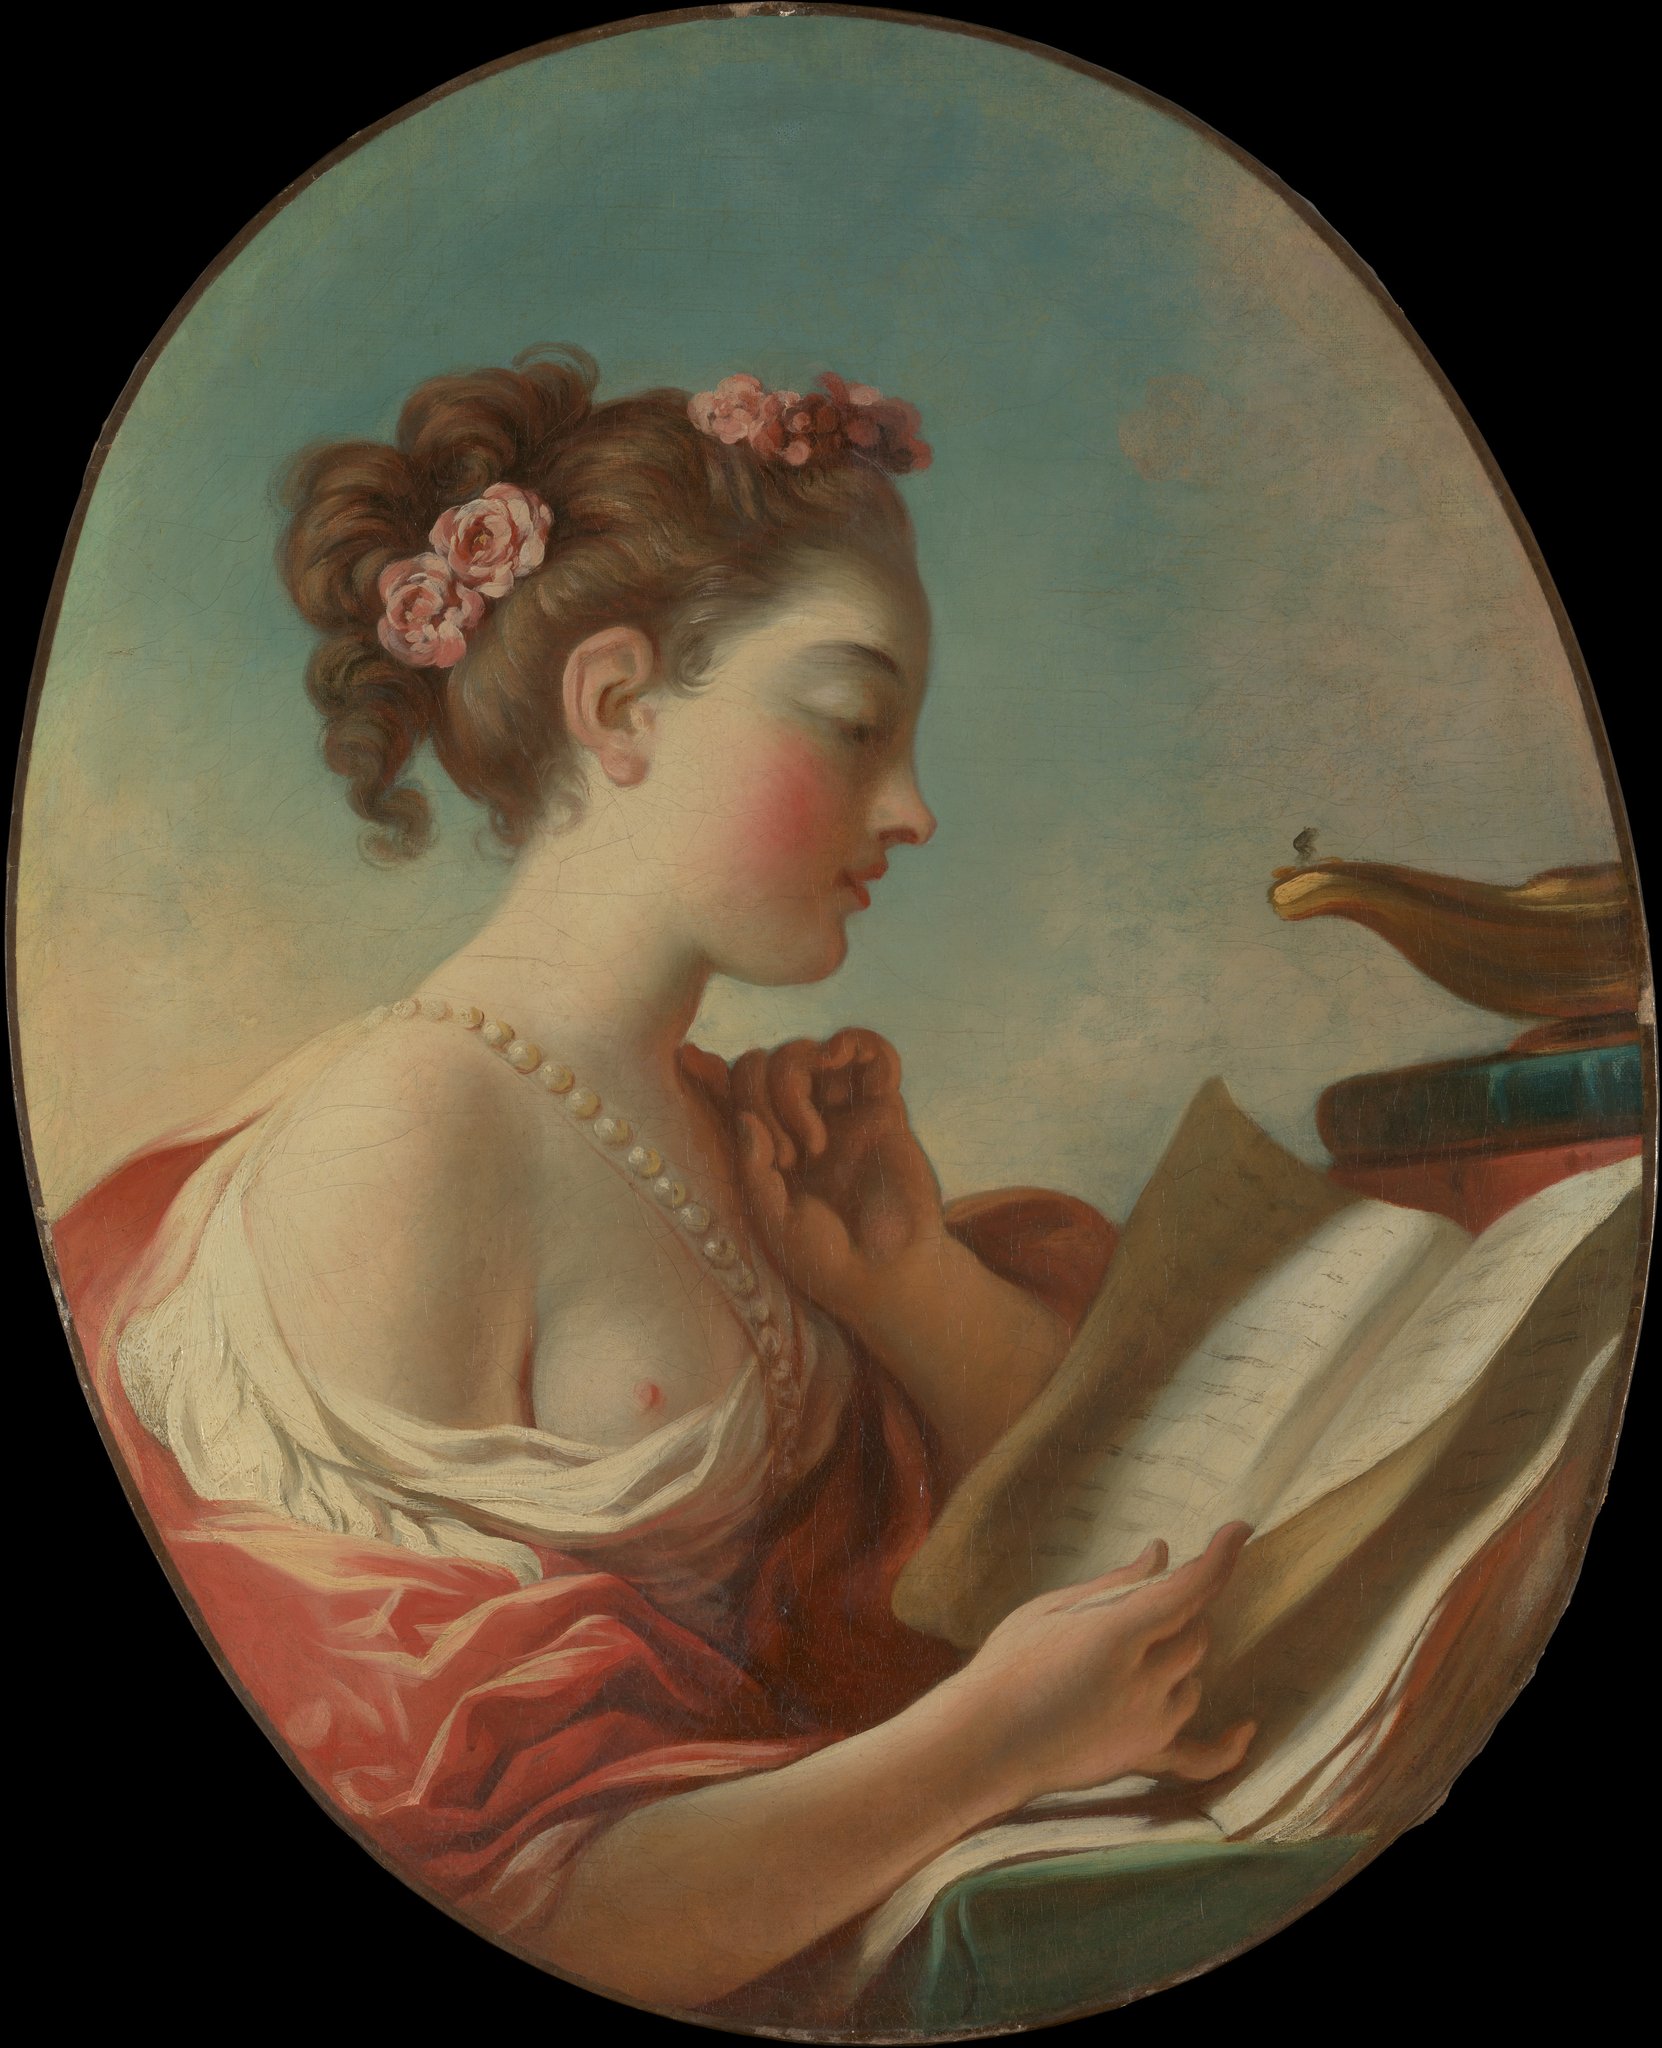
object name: painting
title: Allegory of Vigilance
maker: jean honoré fragonard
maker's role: artist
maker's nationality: french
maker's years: 1732-1806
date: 1772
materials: canvas, oil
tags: profiles,female nudes,reading